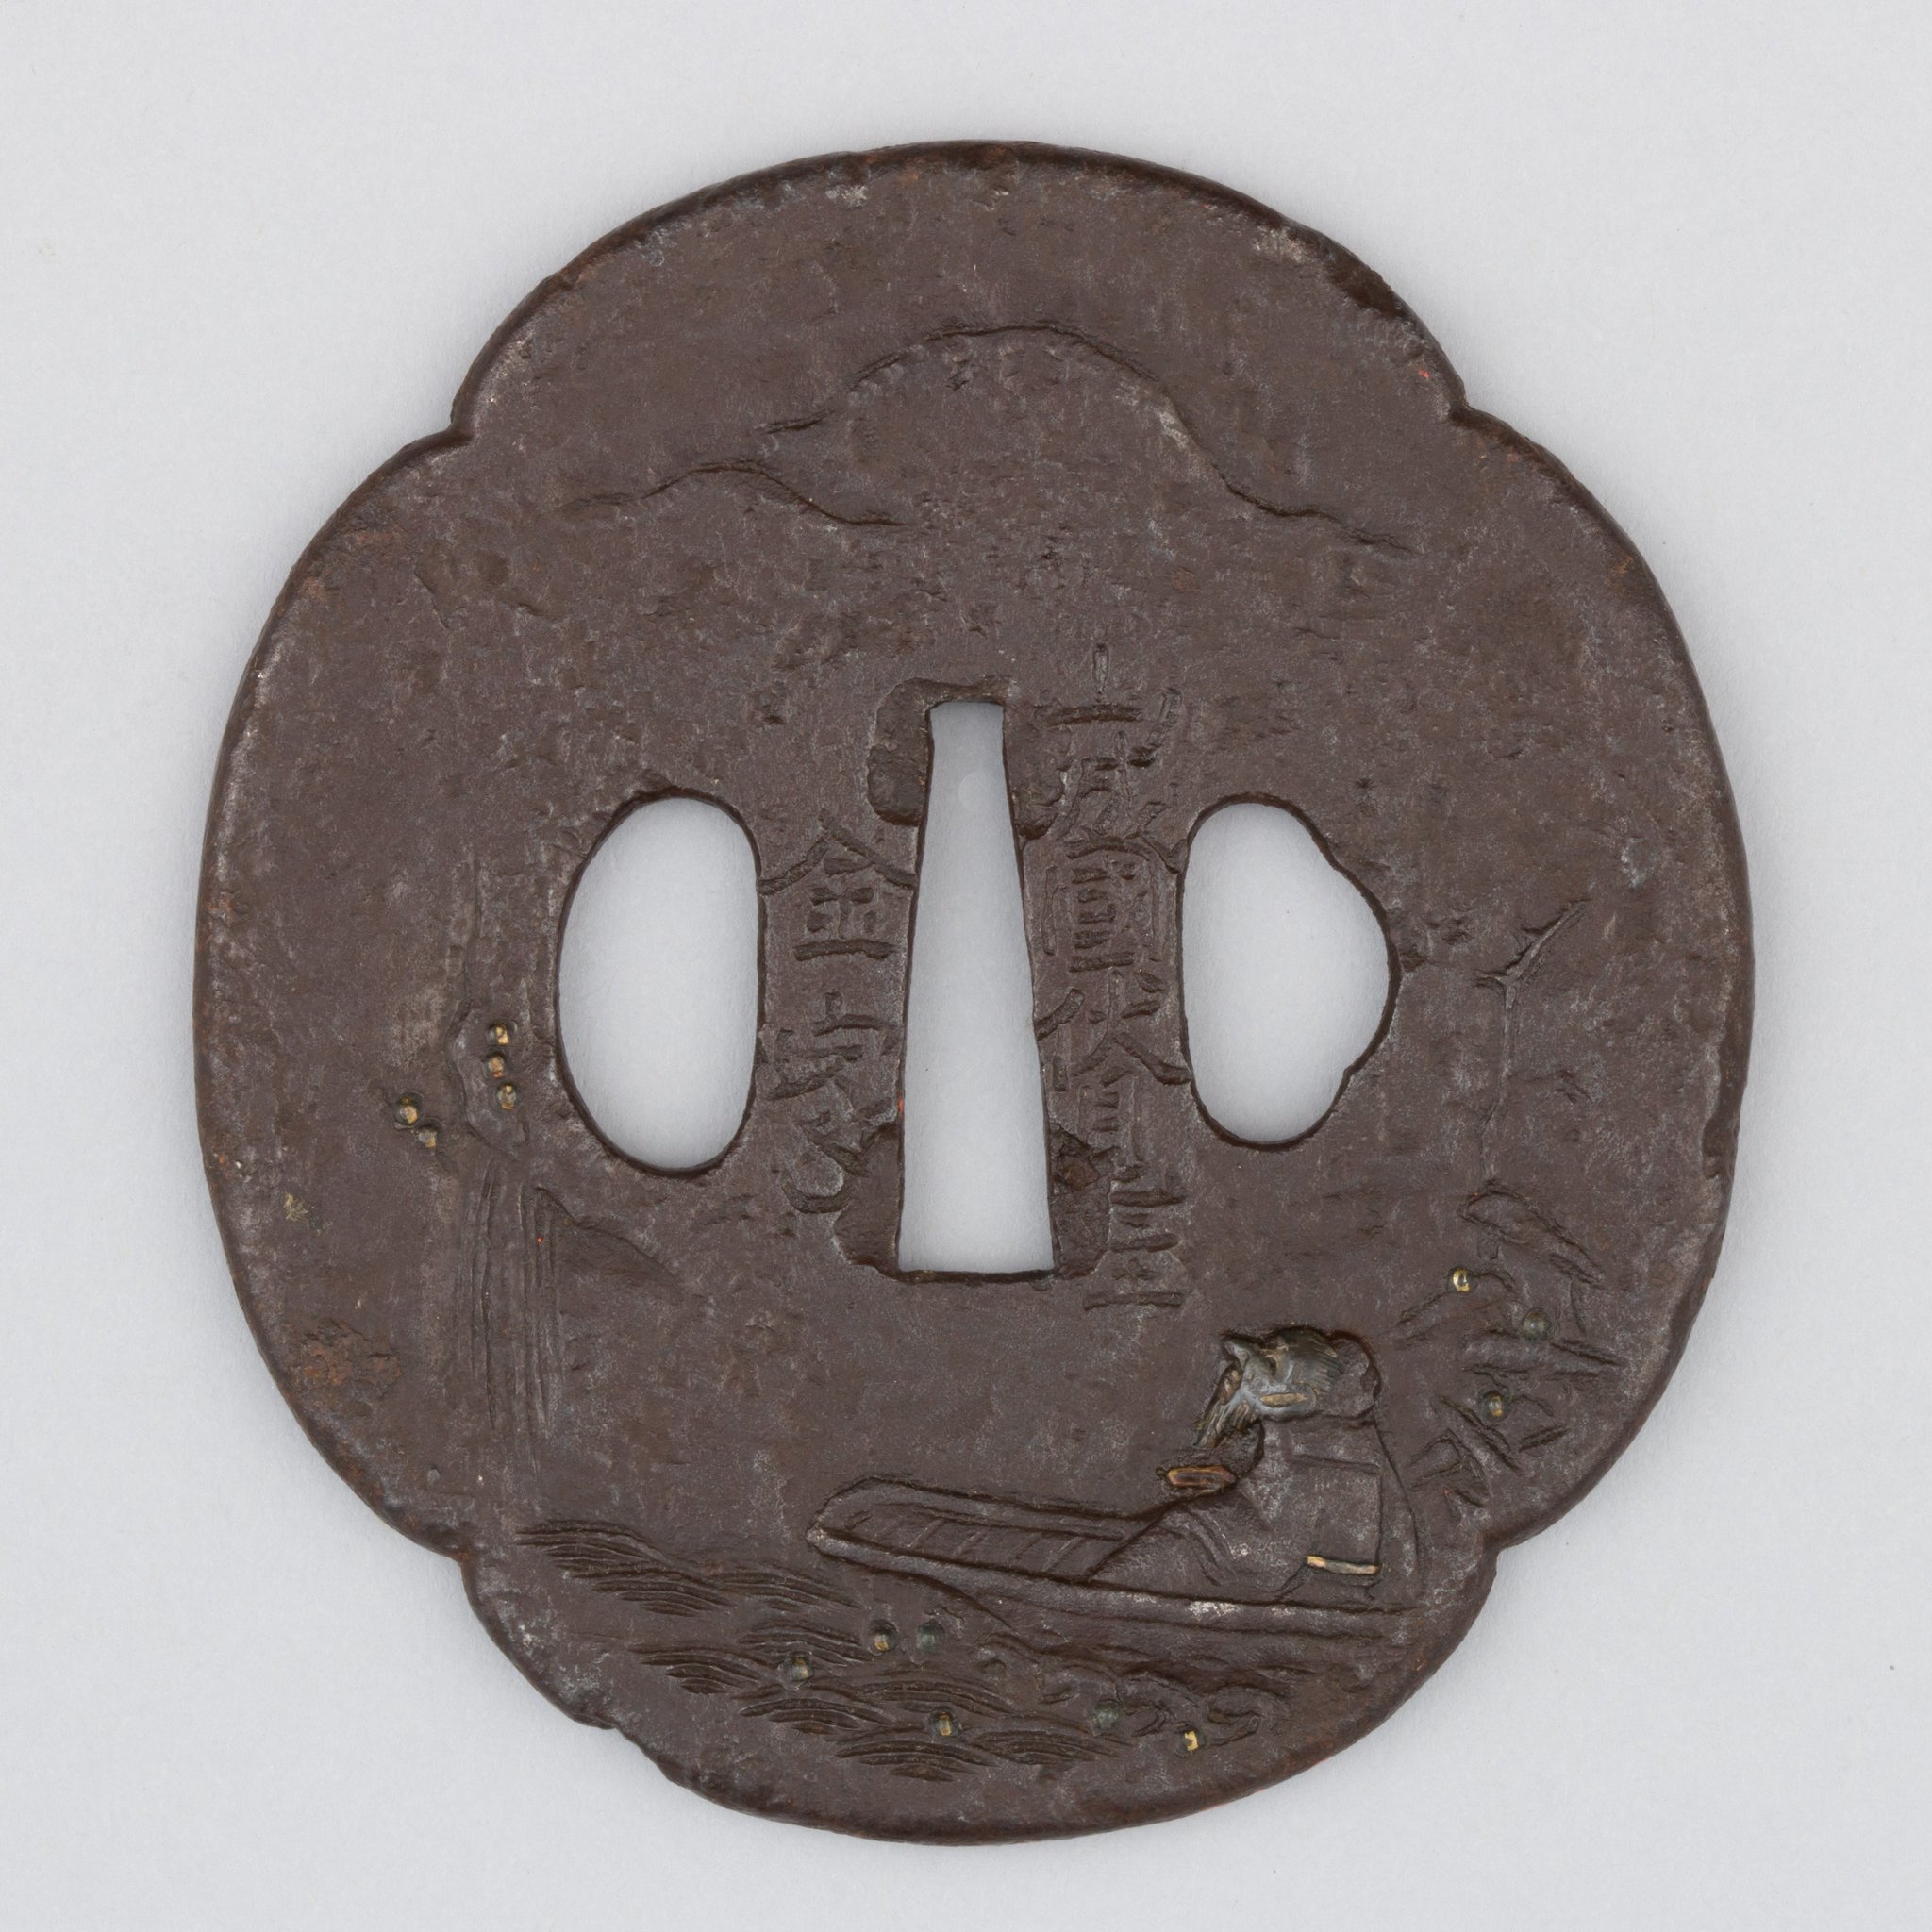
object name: sword guard tsuba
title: Sword Guard (Tsuba)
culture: japanese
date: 1601-1700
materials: iron, silver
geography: japan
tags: men,boats